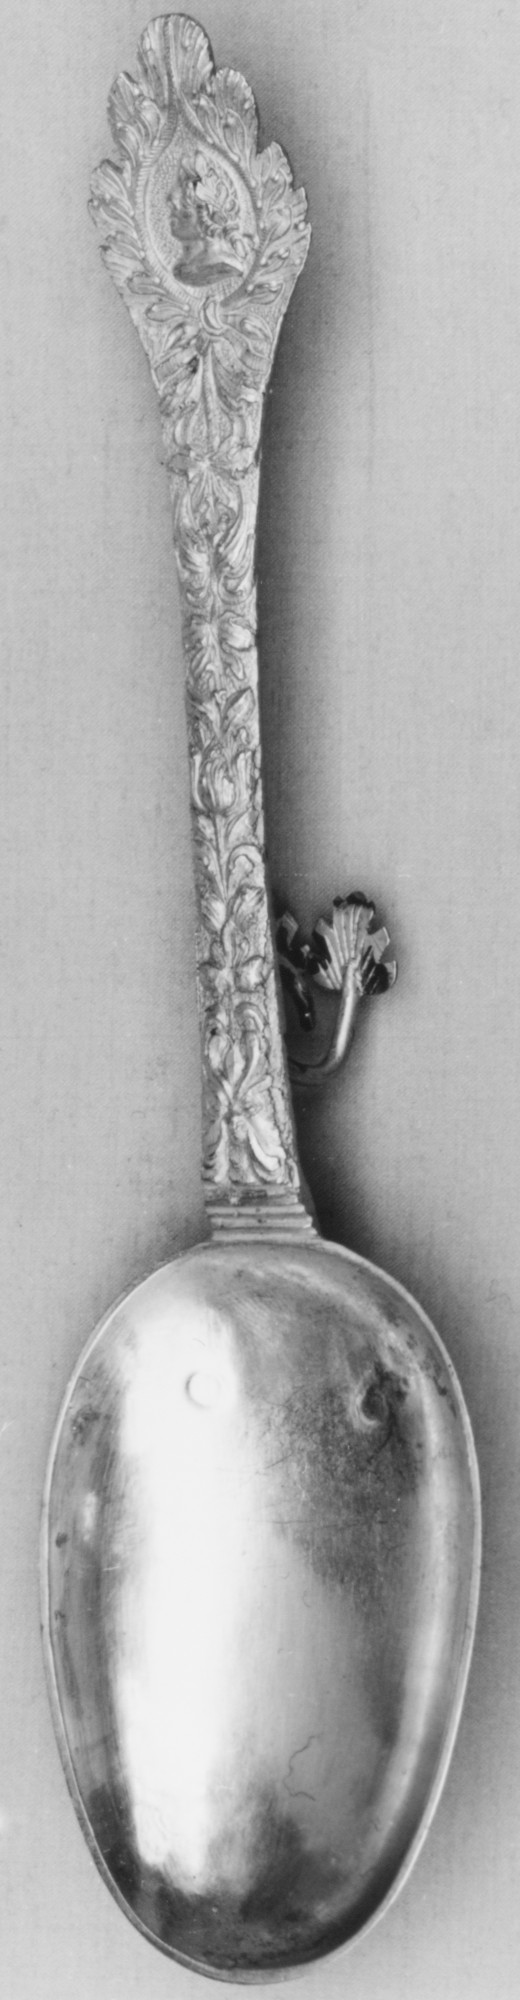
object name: spoon case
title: Split-top spoon with case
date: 1701-1733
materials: silver